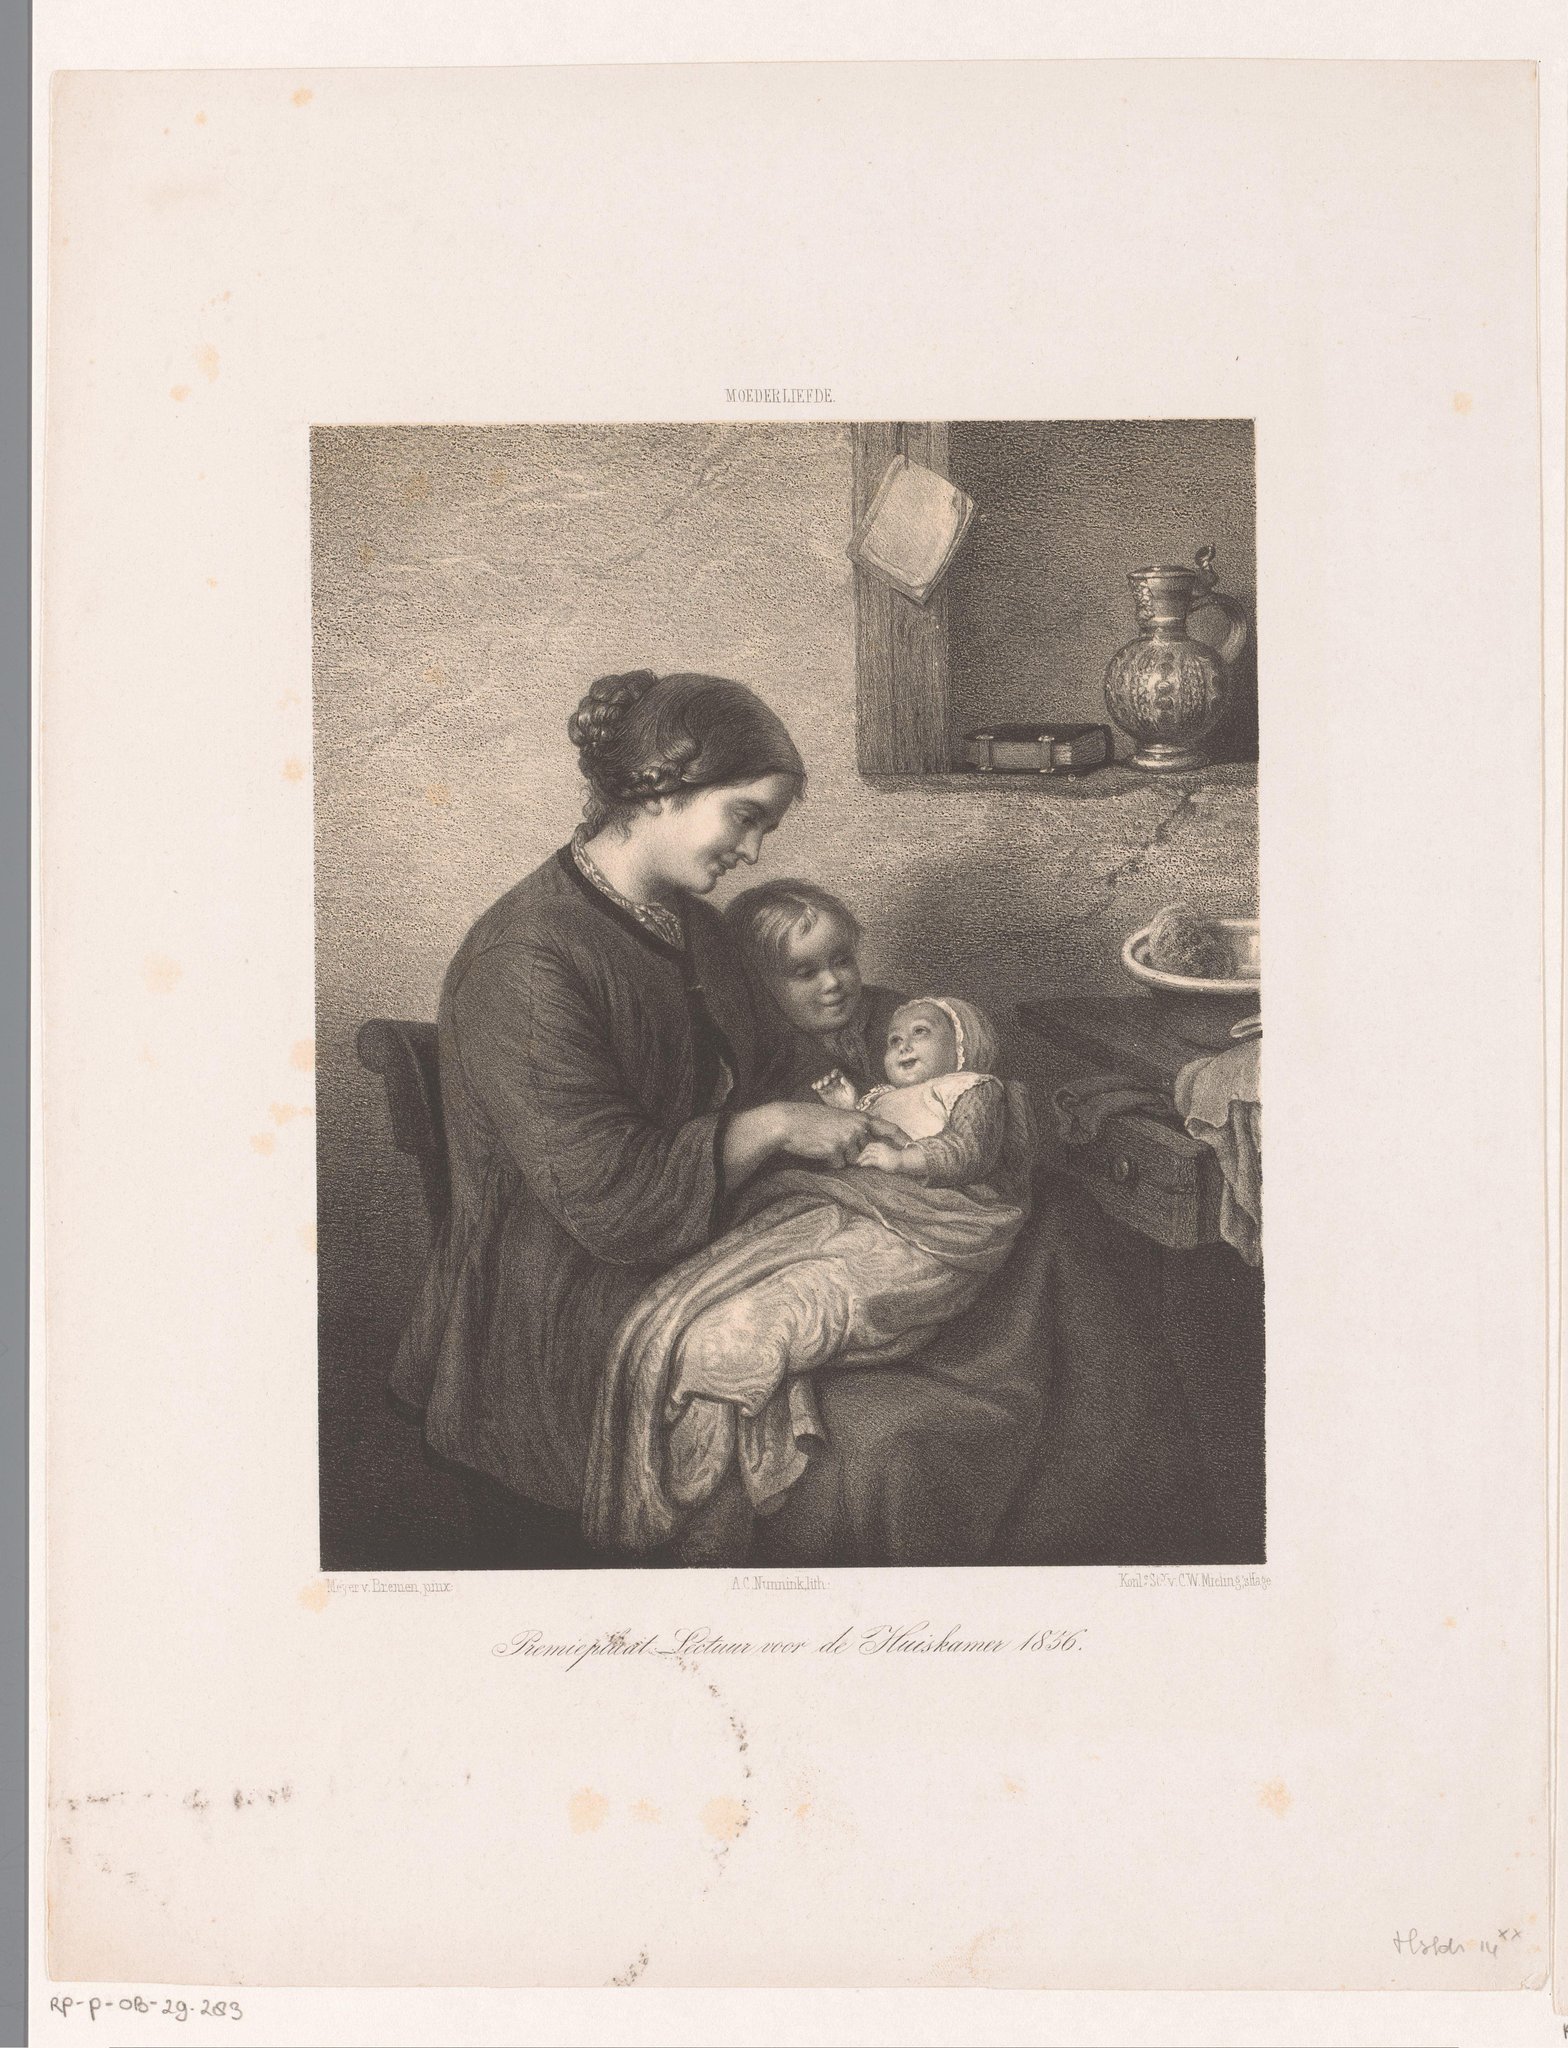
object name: print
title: Moeder met baby op schoot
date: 1856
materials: paper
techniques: lithograph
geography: the hague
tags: infant, baby, mother and child(ren), woman and child(ren) (family group)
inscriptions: collector's mark: Lugt 2228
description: Links van haar staat een jongen. Uitgegeven als premieplaat bij Lectuur voor de Huiskamer in 1856.